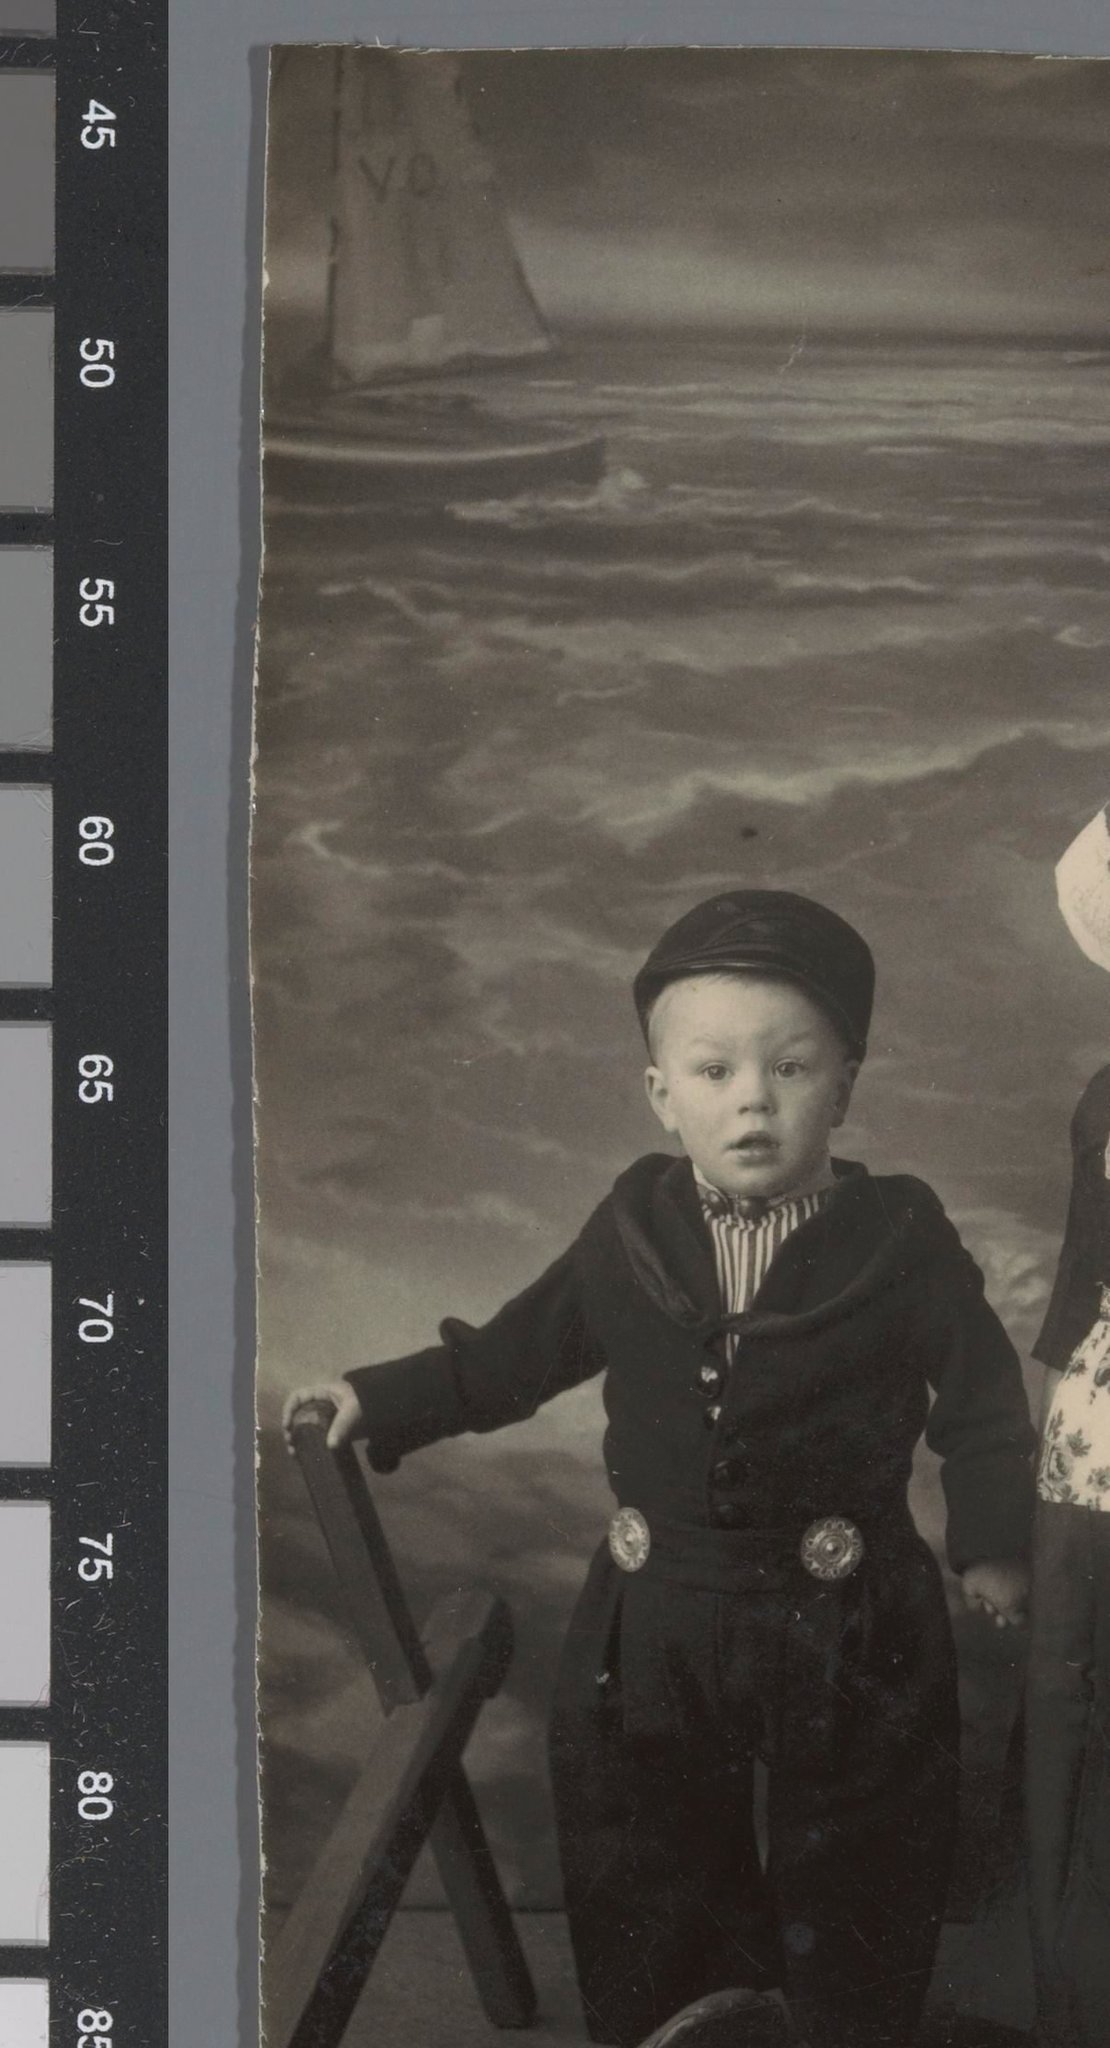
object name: photograph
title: Studioportret van twee kinderen in Volendammer klederdracht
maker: Anonymous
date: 1910-1930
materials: photographic support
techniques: gelatin silver print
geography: volendam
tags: child, folk costume, regional costume, brothers or sisters (second degree family relationships)